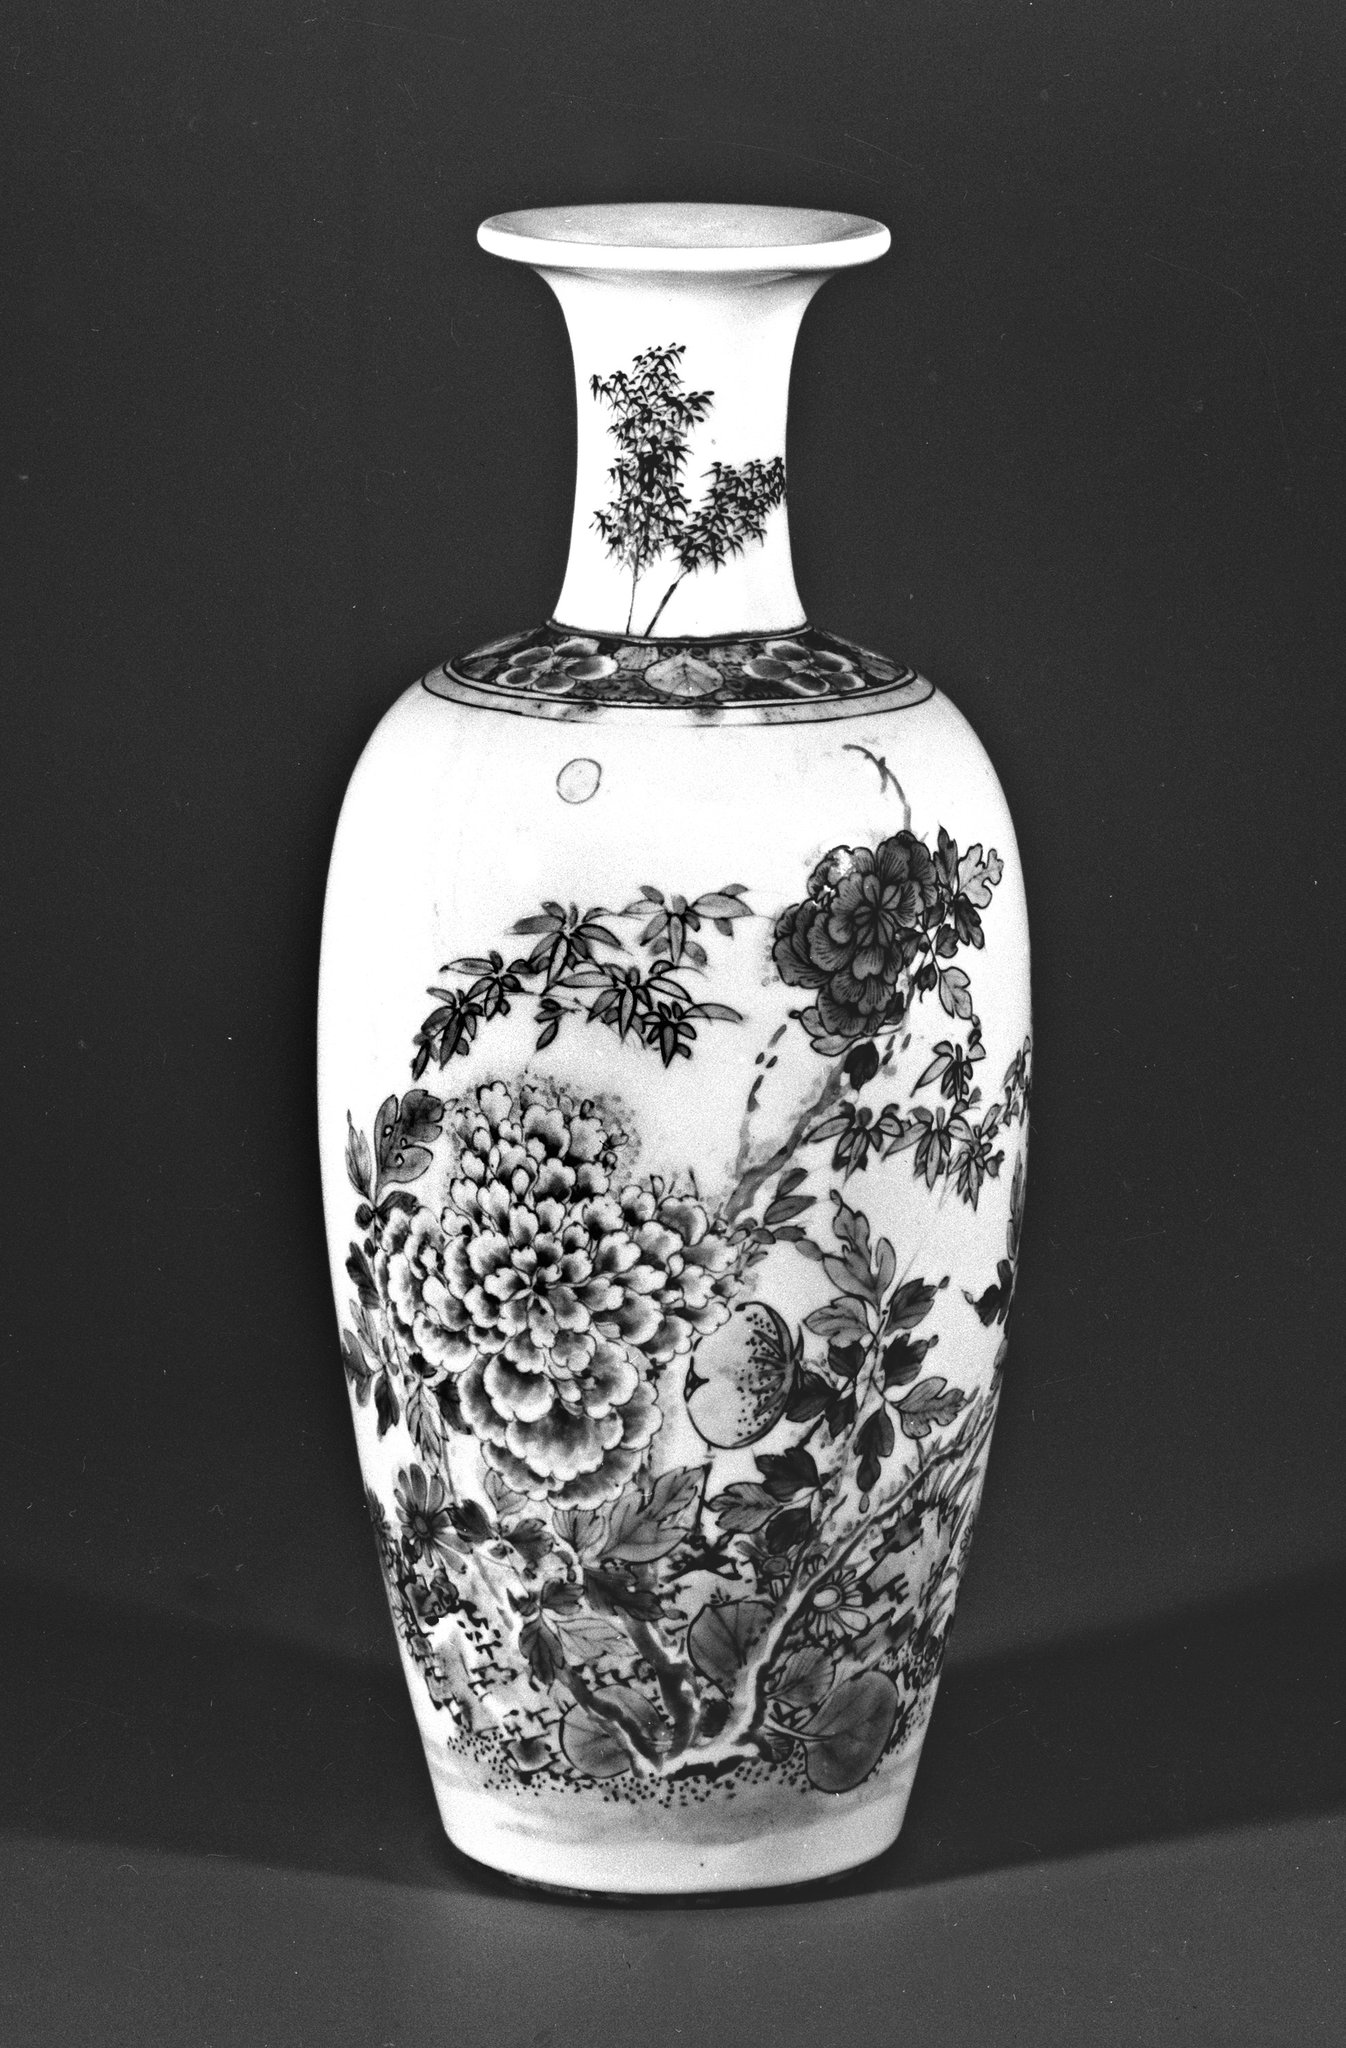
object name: vase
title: Vase with flowers and poem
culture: chinese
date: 1667-1733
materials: enamel, porcelain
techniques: overglaze, painting, polychrome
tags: flowers